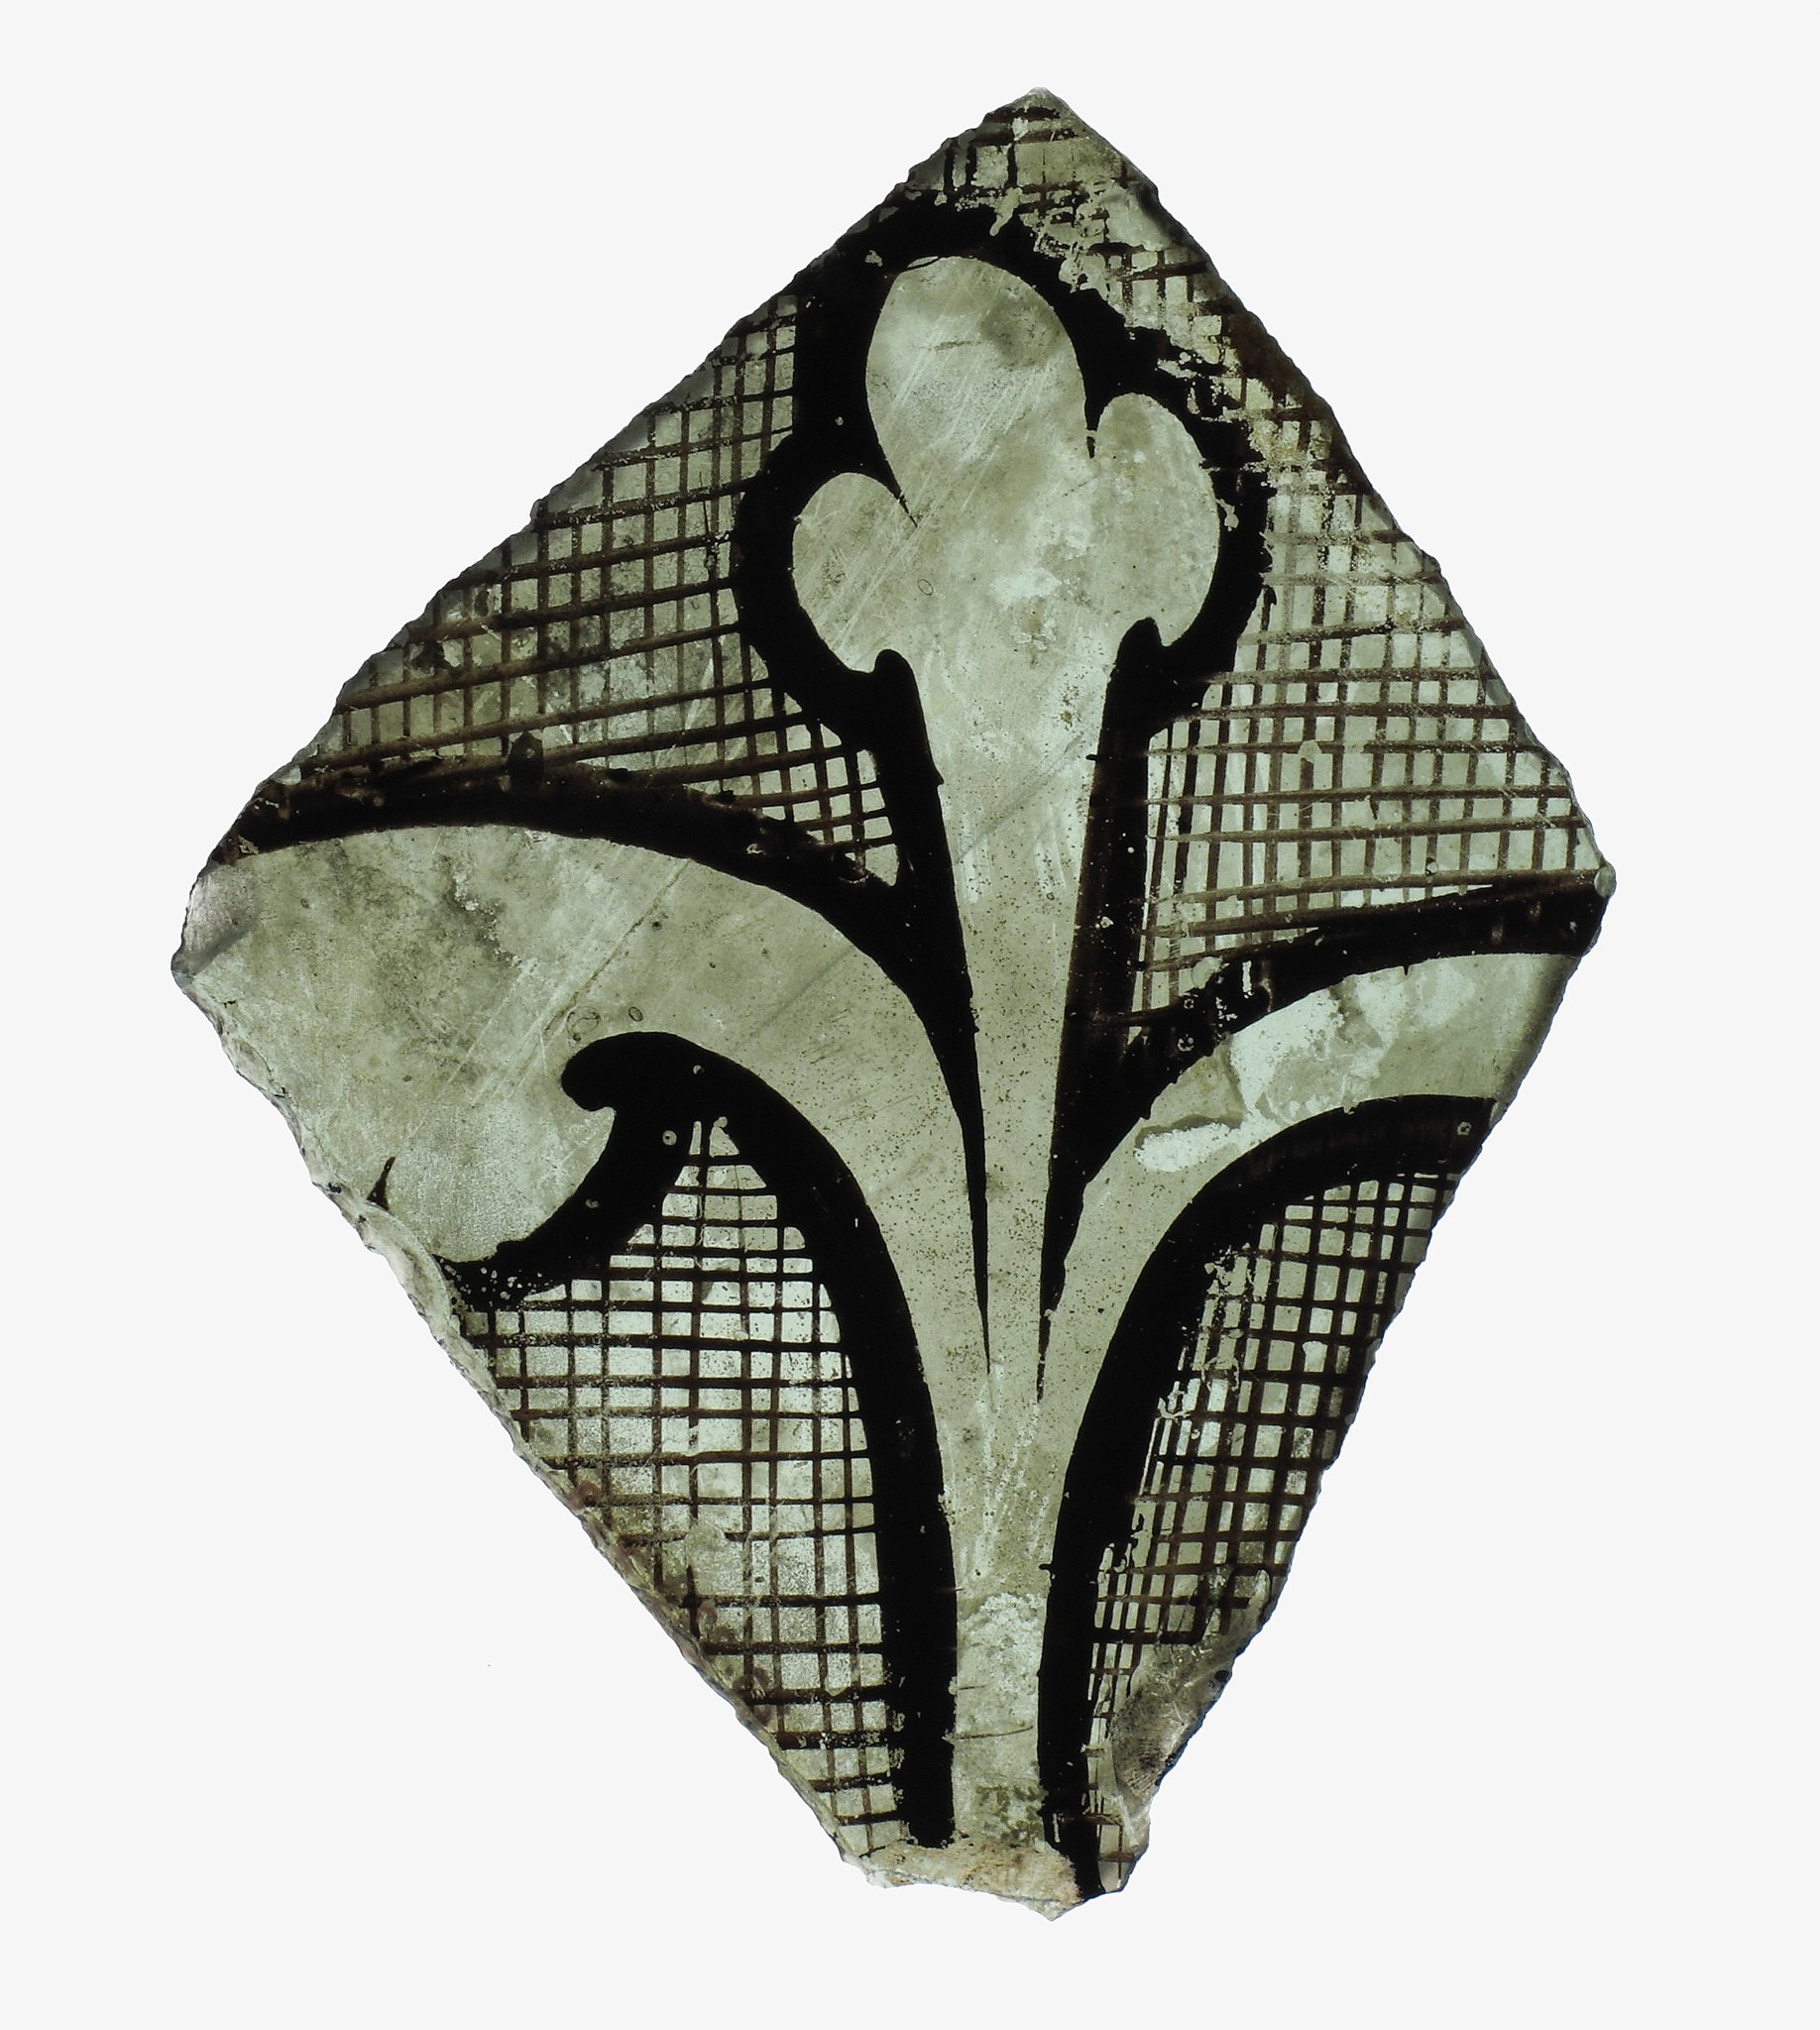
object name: fragment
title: Glass Fragment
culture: french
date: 1201-1300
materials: glass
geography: france